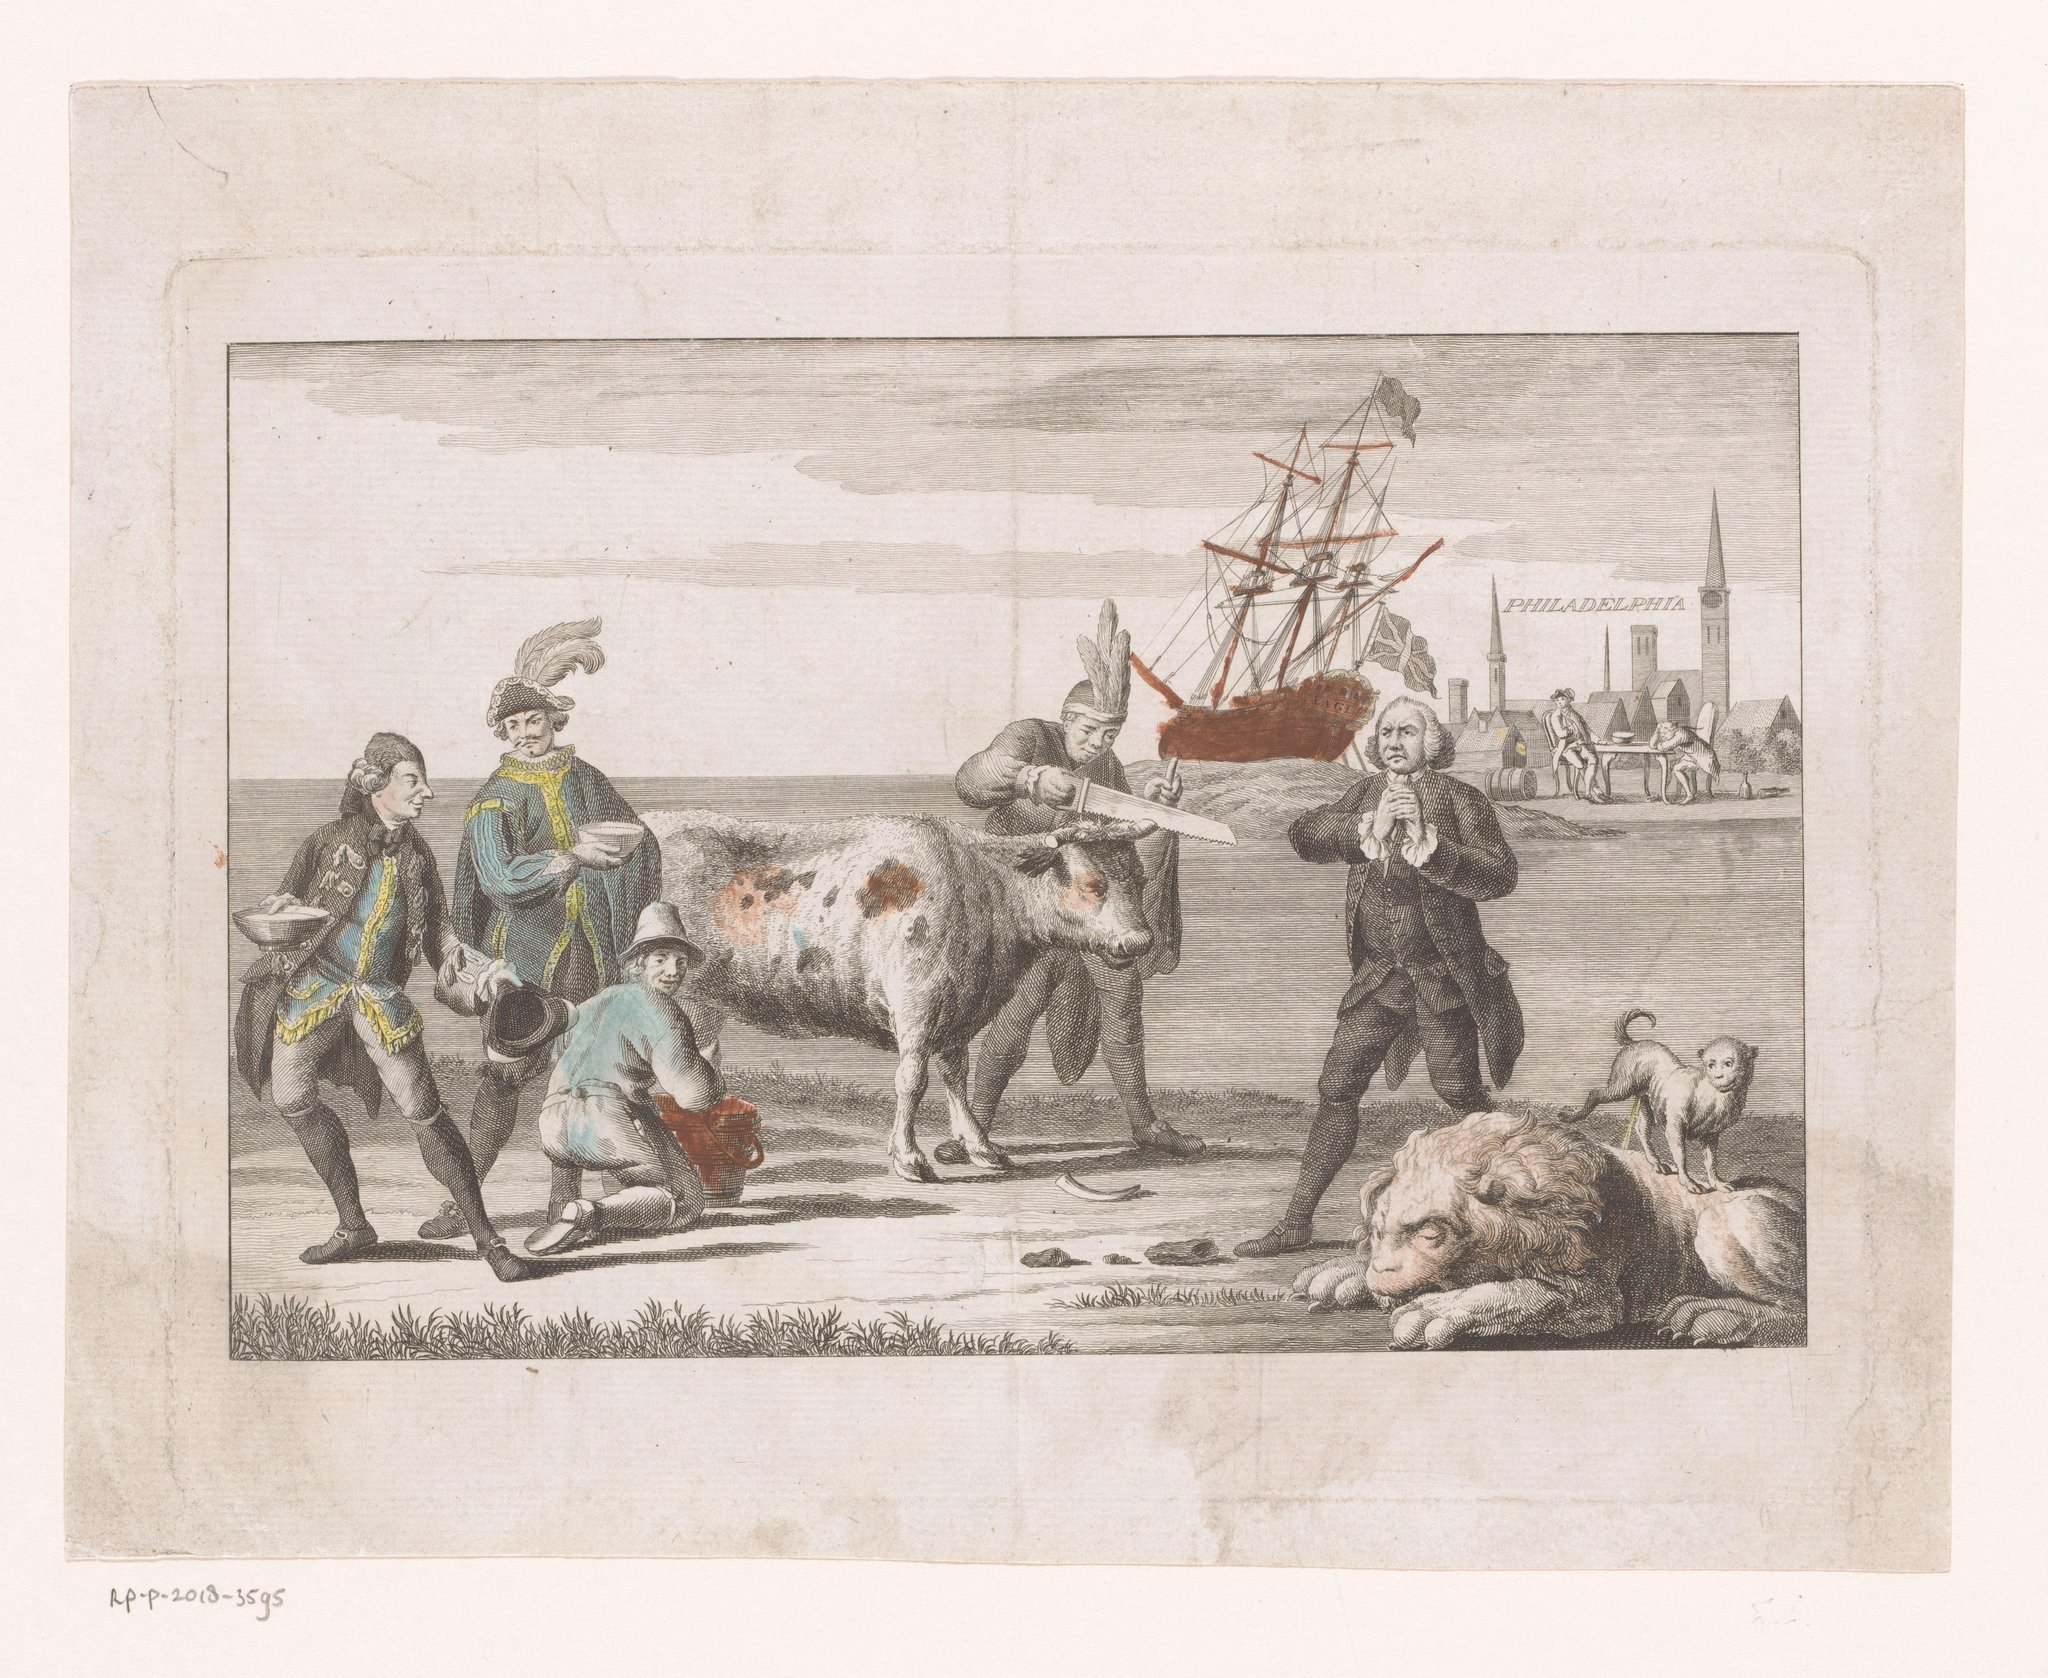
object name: print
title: Gezicht op Philadelphia met op de voorgrond figuren en dieren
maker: Anonymous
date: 1680-1750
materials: paper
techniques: etching, hand coloring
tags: city-view, and landscape with man-made constructions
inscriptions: collector's mark: Lugt 2228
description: Gezicht op Philadelphia met op de voorgrond enkele figuren en dieren. Onder andere een stier waarvan de hoorns worden afgezaagd en een aap (of hond) die over een slapende leeuw plast. Het schip draagt de naam "Eagle".